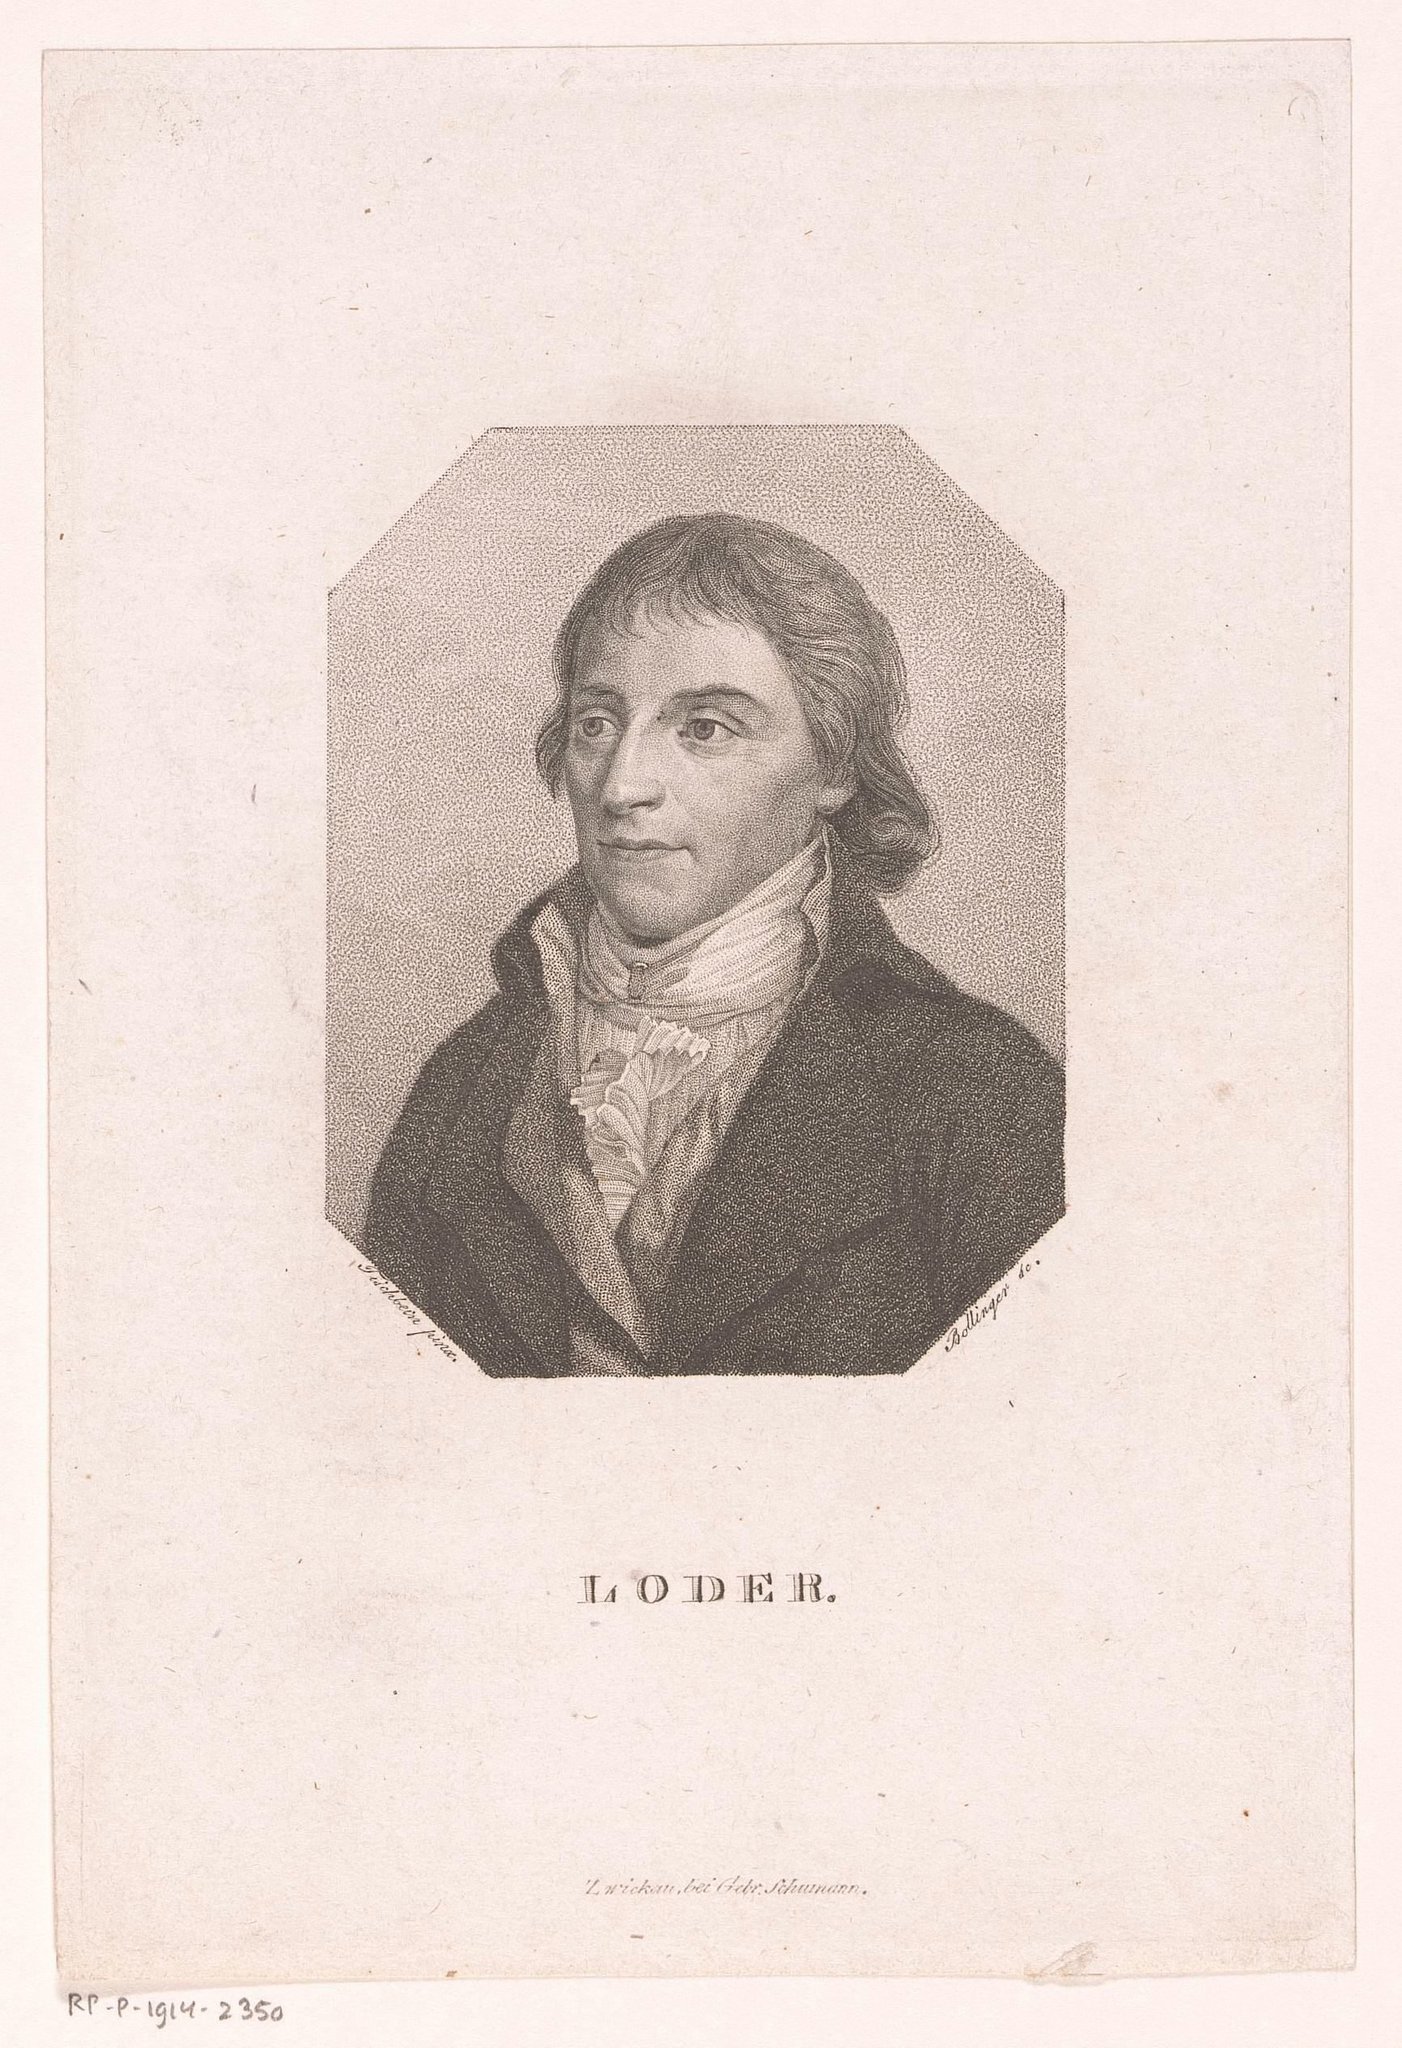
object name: print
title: Bildnisse der berühmtesten Menschen aller Völker und Zeiten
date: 1818-1832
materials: paper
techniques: stippling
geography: berlin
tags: historical persons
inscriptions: collector's mark: Lugt 2228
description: Prent gebruikt door de serie 'Bildnisse der berühmtesten Menschen aller Völker und Zeiten' van de gebroeders Schumann, uitgegeven in 1818-1832 te Zwickau.